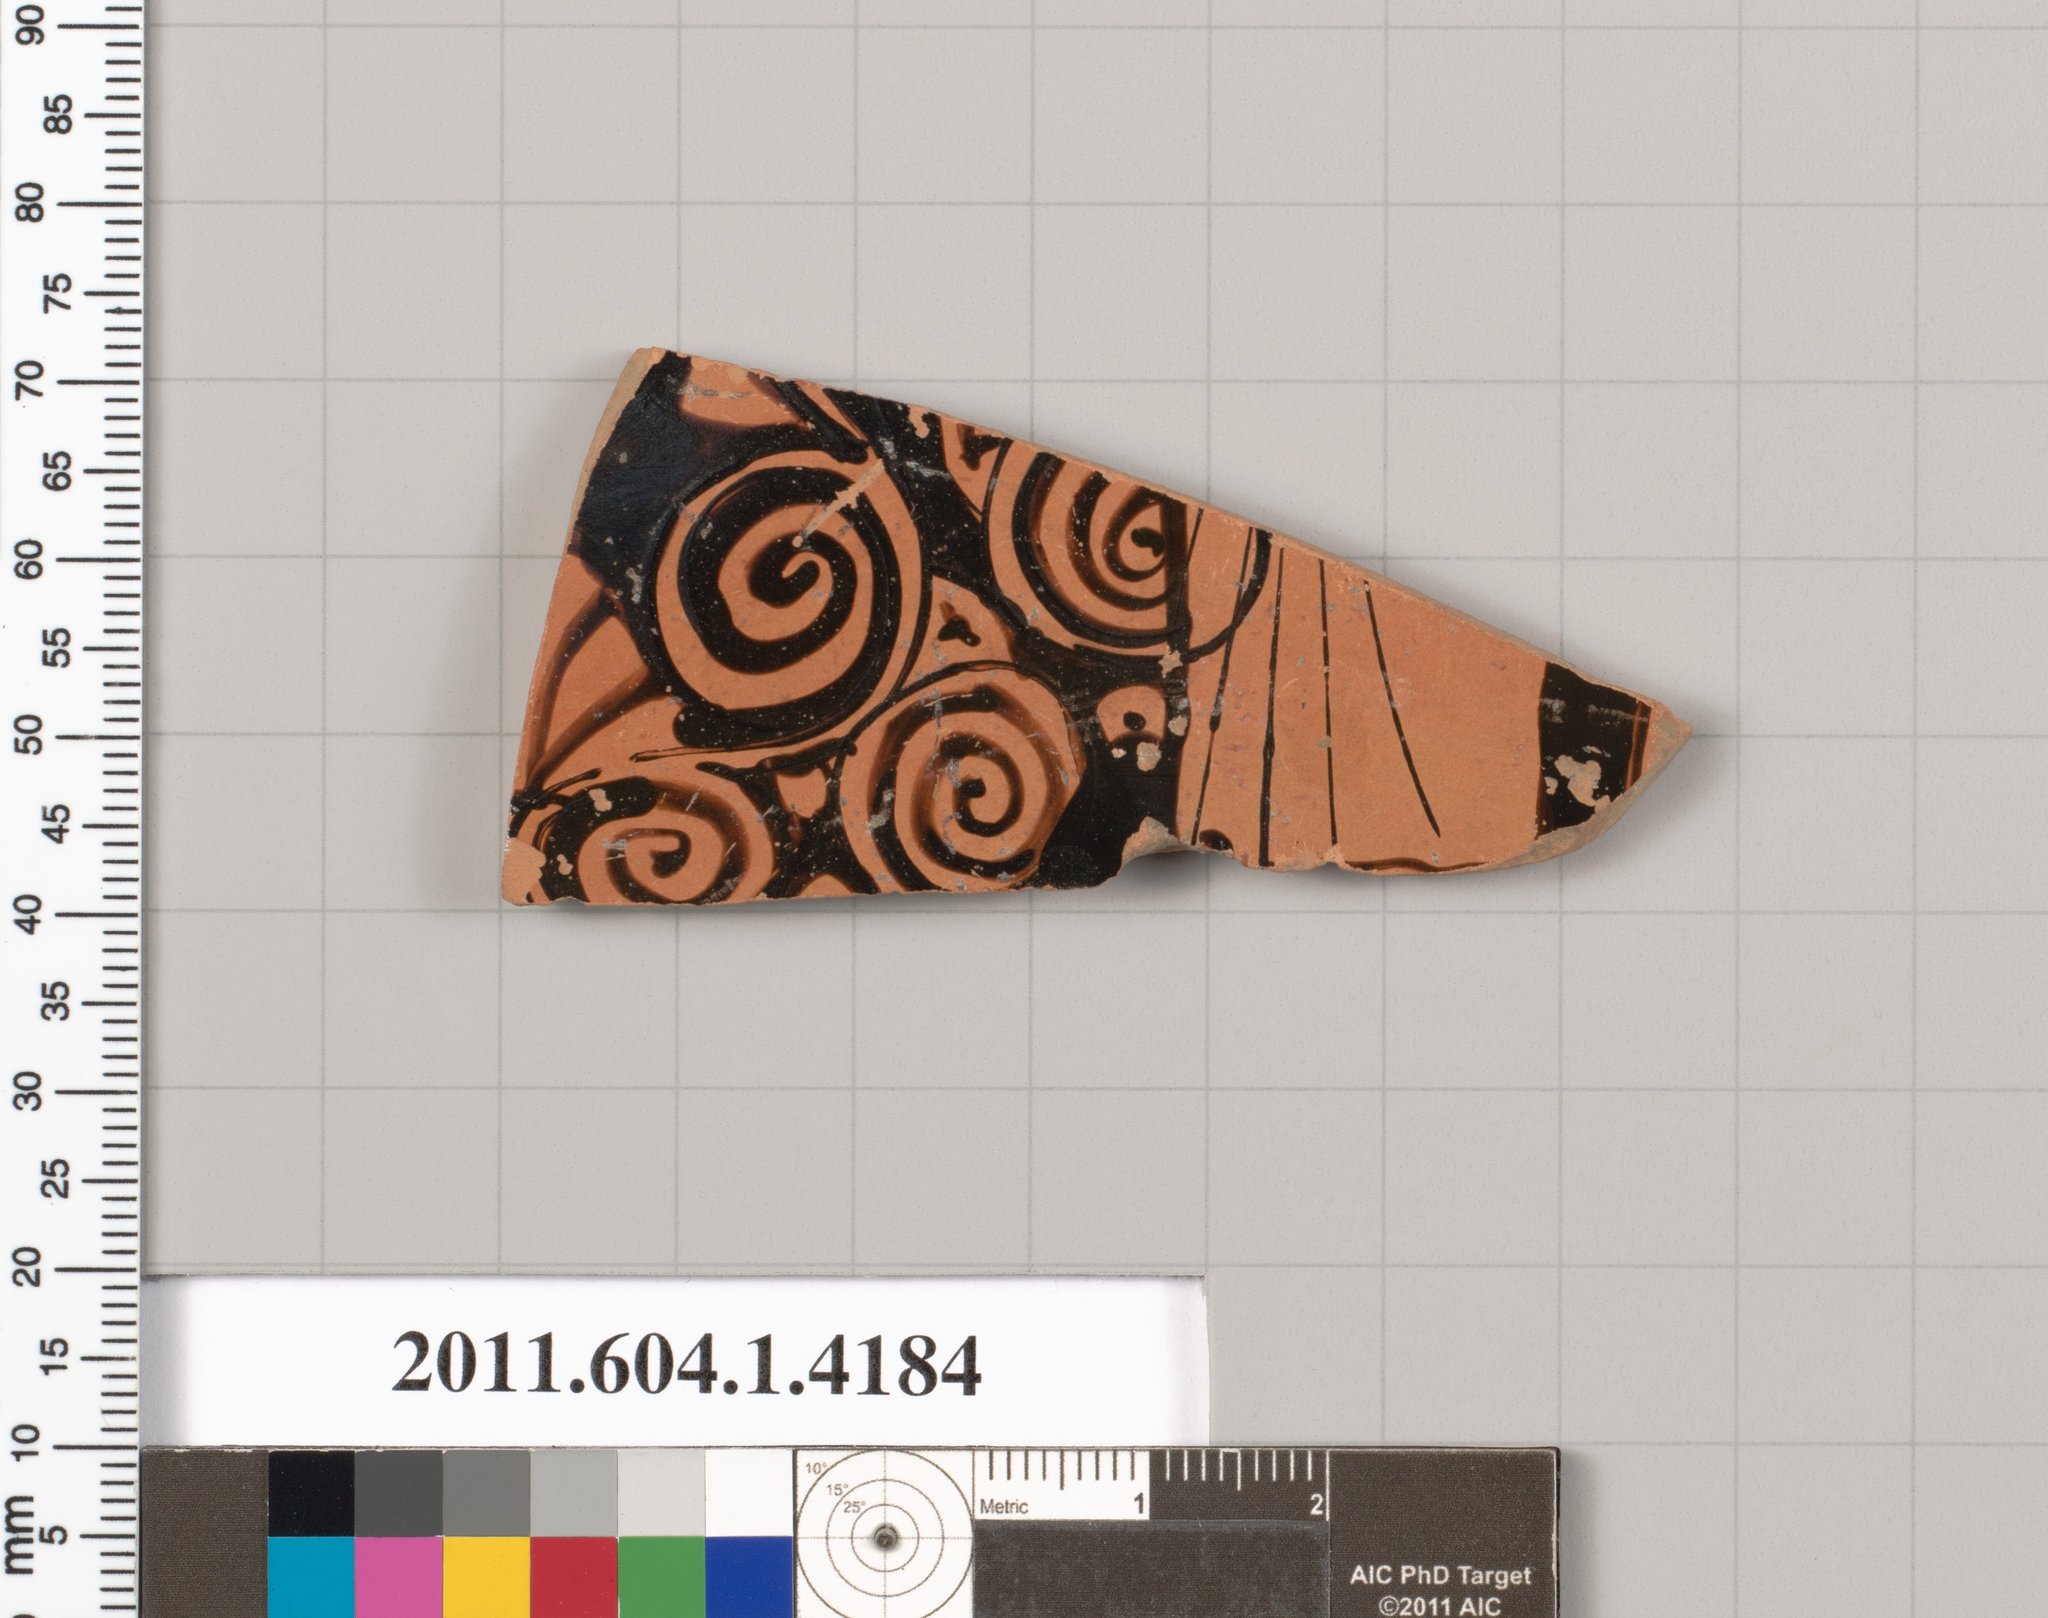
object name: kylix fragment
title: Terracotta fragment of a kylix (drinking cup)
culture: greek, attic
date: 475-451 BCE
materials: terracotta